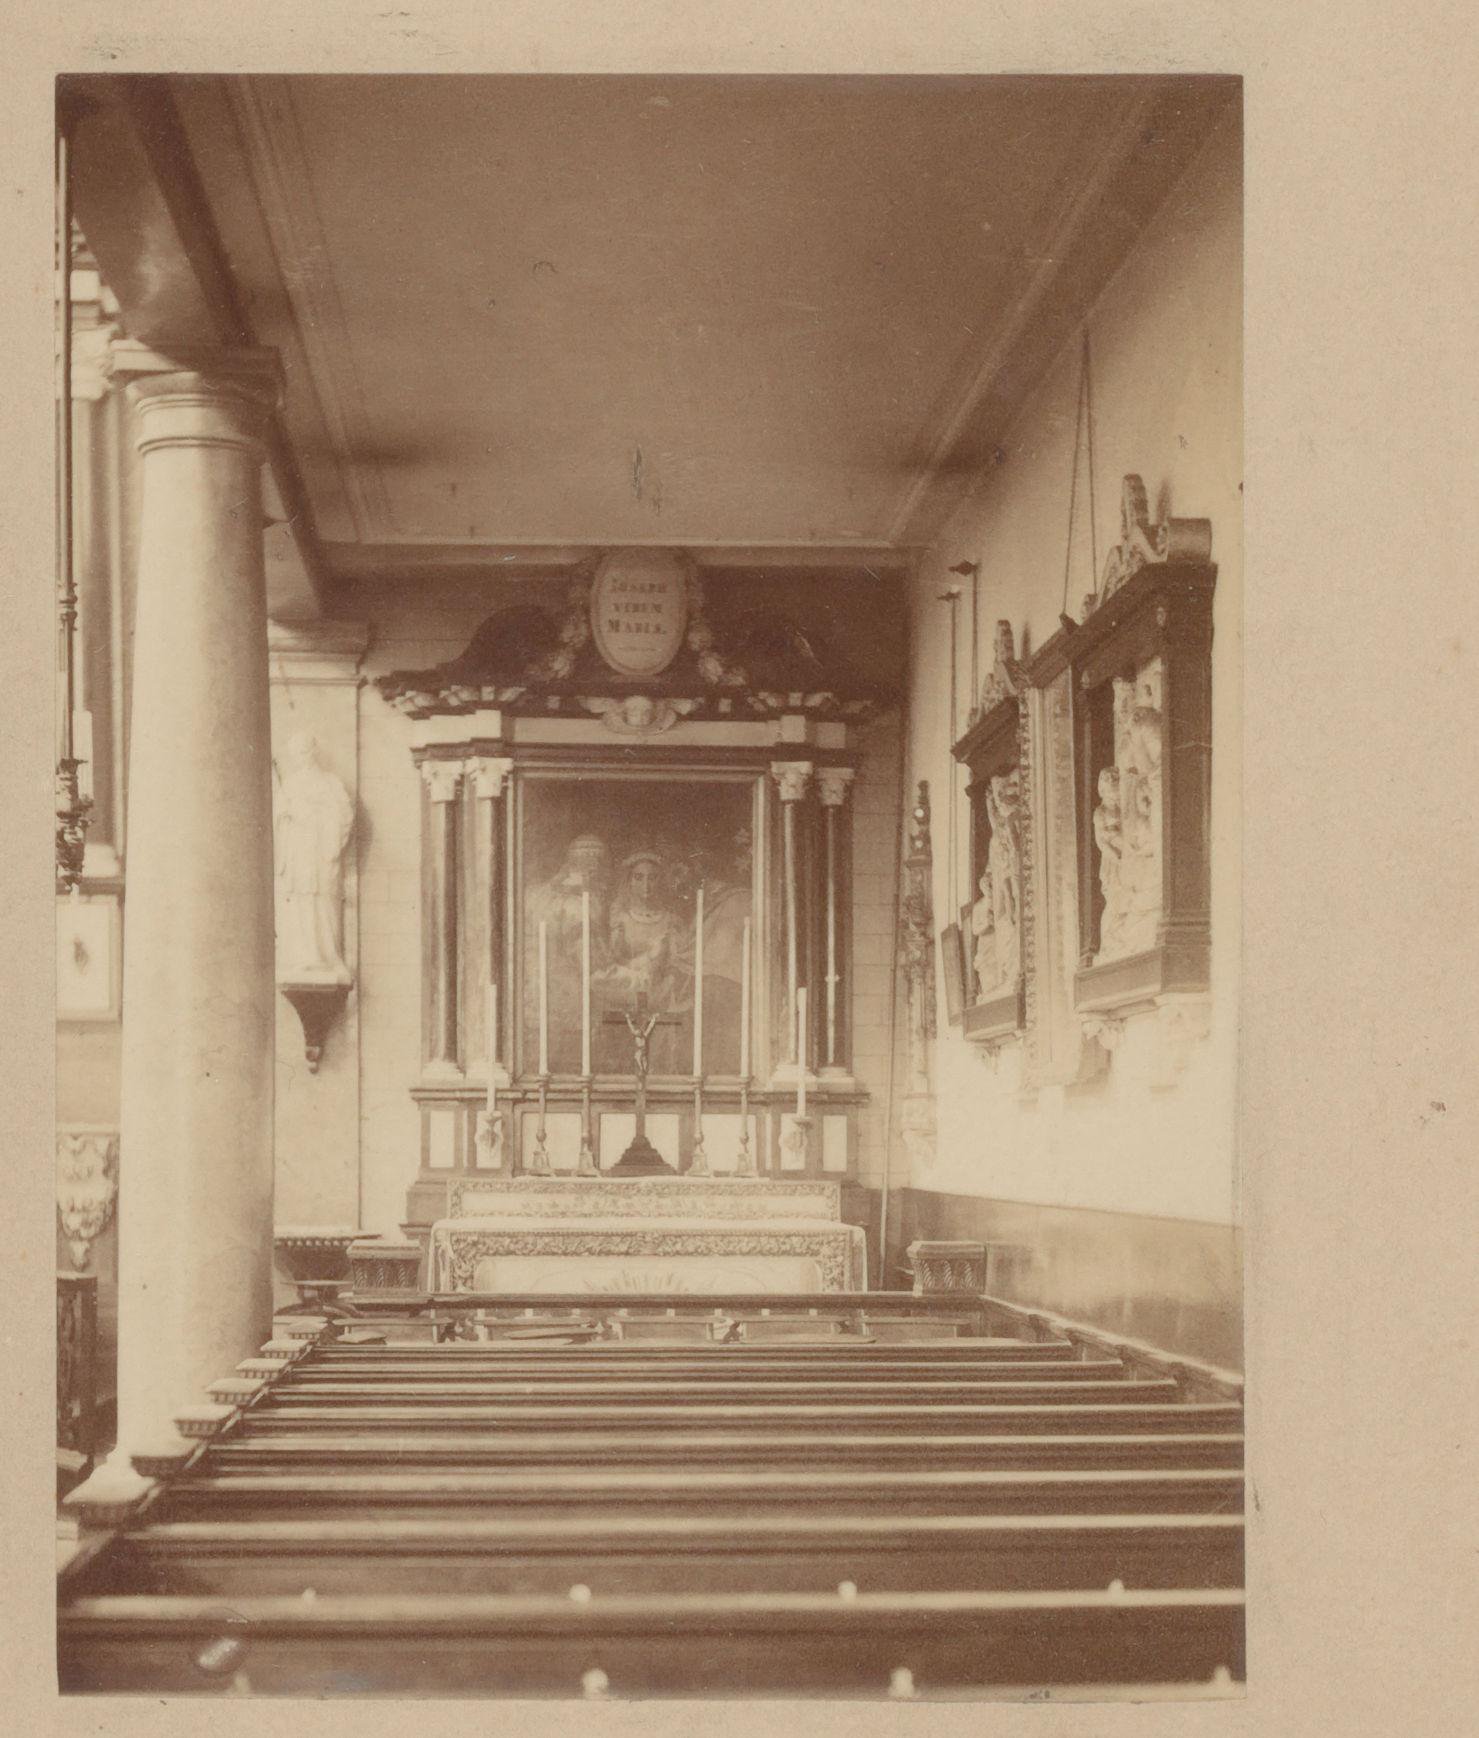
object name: photograph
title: Altaar in de rechterzijbeuk van de Krijtberg te Amsterdam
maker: Anonymous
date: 1860-1881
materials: paper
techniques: albumen print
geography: amsterdam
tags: interior of church, altar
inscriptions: collector's mark: Lugt 1641b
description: Onderwerpsrubriek binnen de Atlas Amsterdam: Kerkwezen: R.K. Gemeenten: Begijnhof t/m Petrus en Paulus.